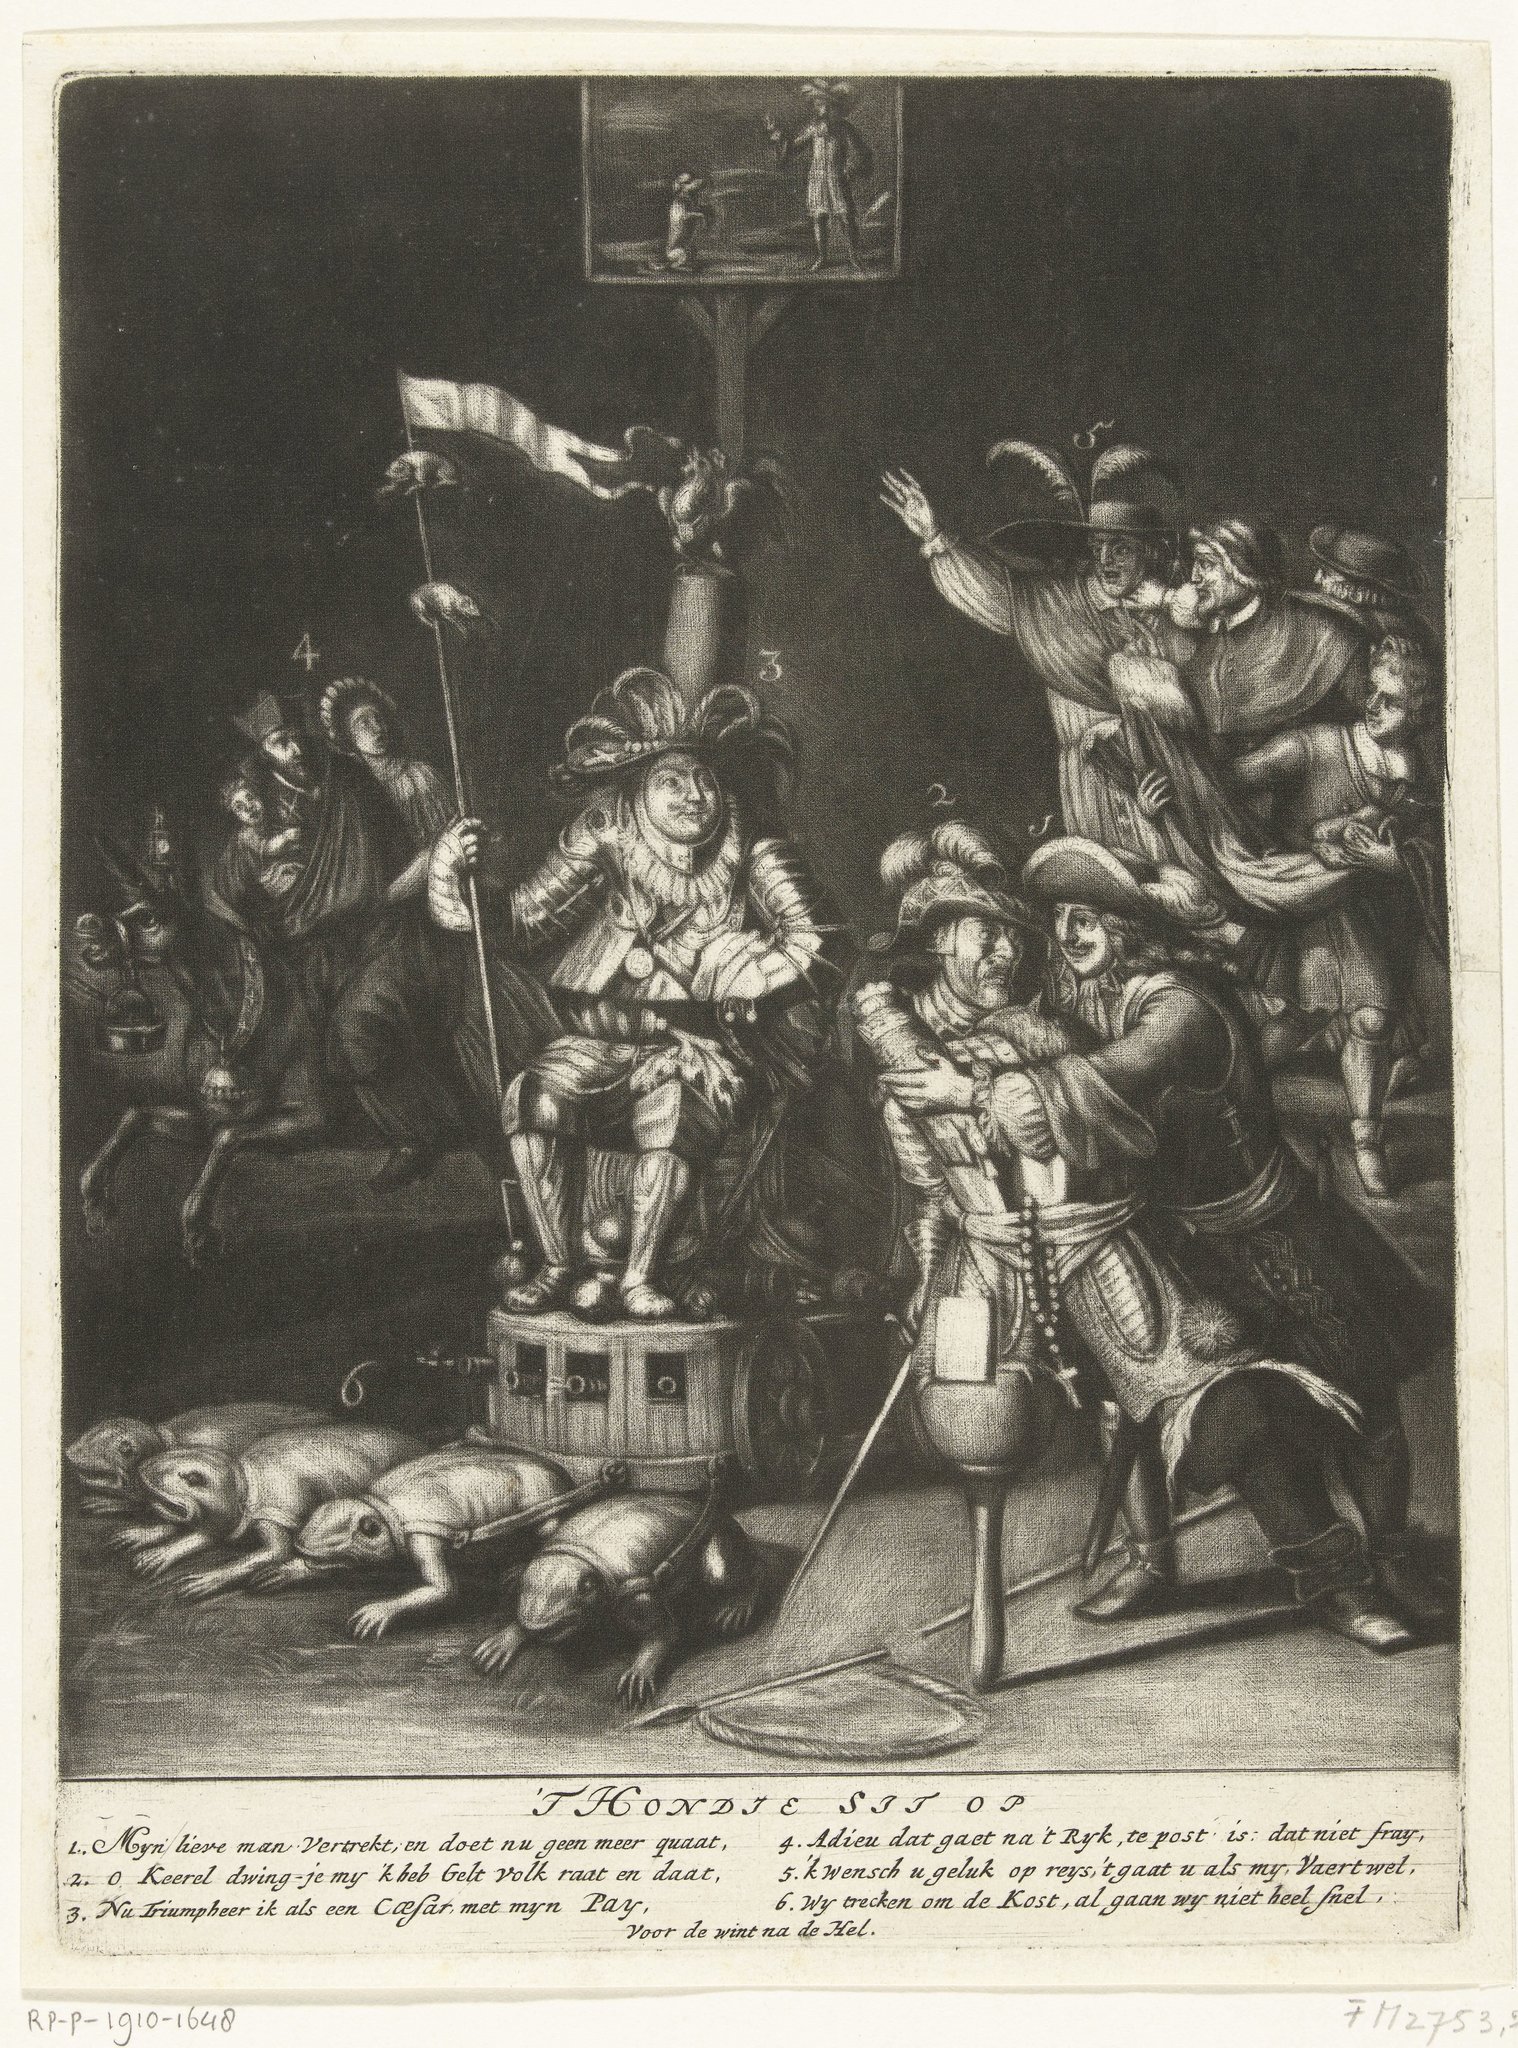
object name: print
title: Spotprent op Lodewijk XIV en de dauphin, 1689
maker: Anonymous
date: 1689-1690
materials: paper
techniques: mezzotint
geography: northern netherlands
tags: lodewijk xiv (koning van frankrijk), paris, venice, rome, clergyman, alexander viii, dauphin van frankrijk lodewijk, london, dogs (circus performance)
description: Spotprent op Lodewijk XIV en Lodewijk, dauphin van Frankrijk, 1689. De dauphin op een triomfwagen getrokken door padden, zijn vader Lodewijk XIV wordt door een soldaat tegengehouden ten strijde te trekken. Rechts de paus en de kardinaal von Fürstenberg. Links vluchten de pater Peters (Edward Petre) met Maria van Modena en de prins van Wales, het molenaarskind Jacobus Frans Eduard, op een ezel. Op de achtergrond op een paal een voorstelling van een man met een opzittend hondje. In het onderschrift de legenda 1-6 en de spreuk: Voor de wint na de Hel.